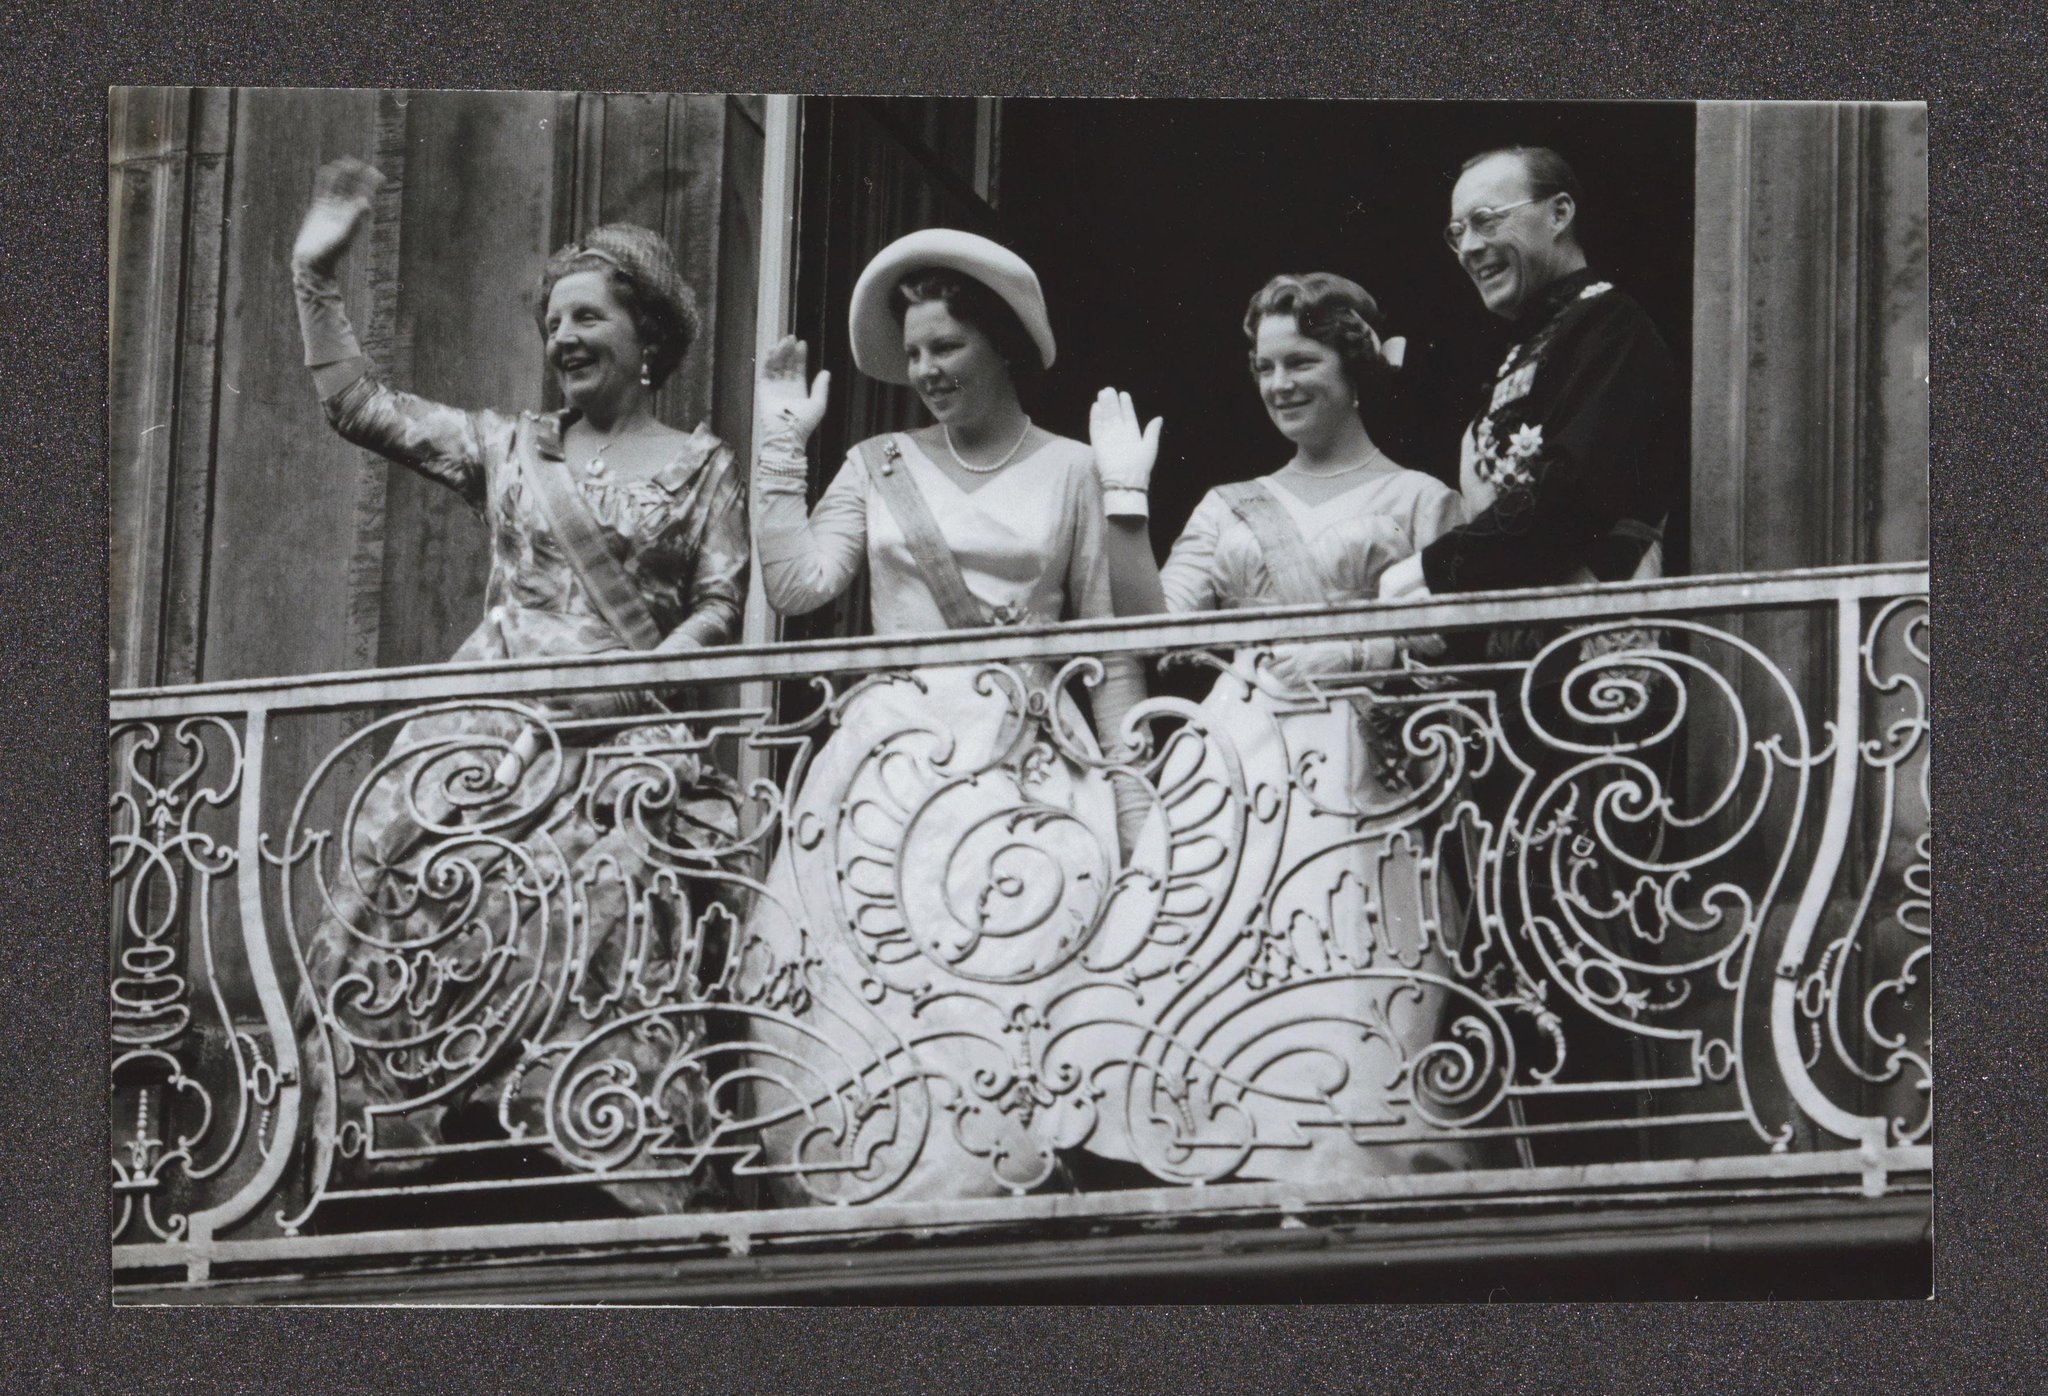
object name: photograph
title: Koningin Juliana, Prinses Beatrix, Prinses Irene en Prins Bernhard op het balkon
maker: joop van bilsen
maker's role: fotograaf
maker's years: 1905-1977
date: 1962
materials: paper, photographic support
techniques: gelatin silver print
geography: netherlands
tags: utrecht, bernhard (prins der nederlanden), beatrix (koningin der nederlanden), juliana of the netherlands, the hague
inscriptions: annotation: ‘Na de opening van de Staten Generaal vertrok het Kon. Gezin naar het Paleis op het Lange Voorhout. Op het balcon werd een enthousiaste groet gebracht aan het toegestroomde publiek. Foto ANEFO 16-9-1958 foto Jo van Bilsen’